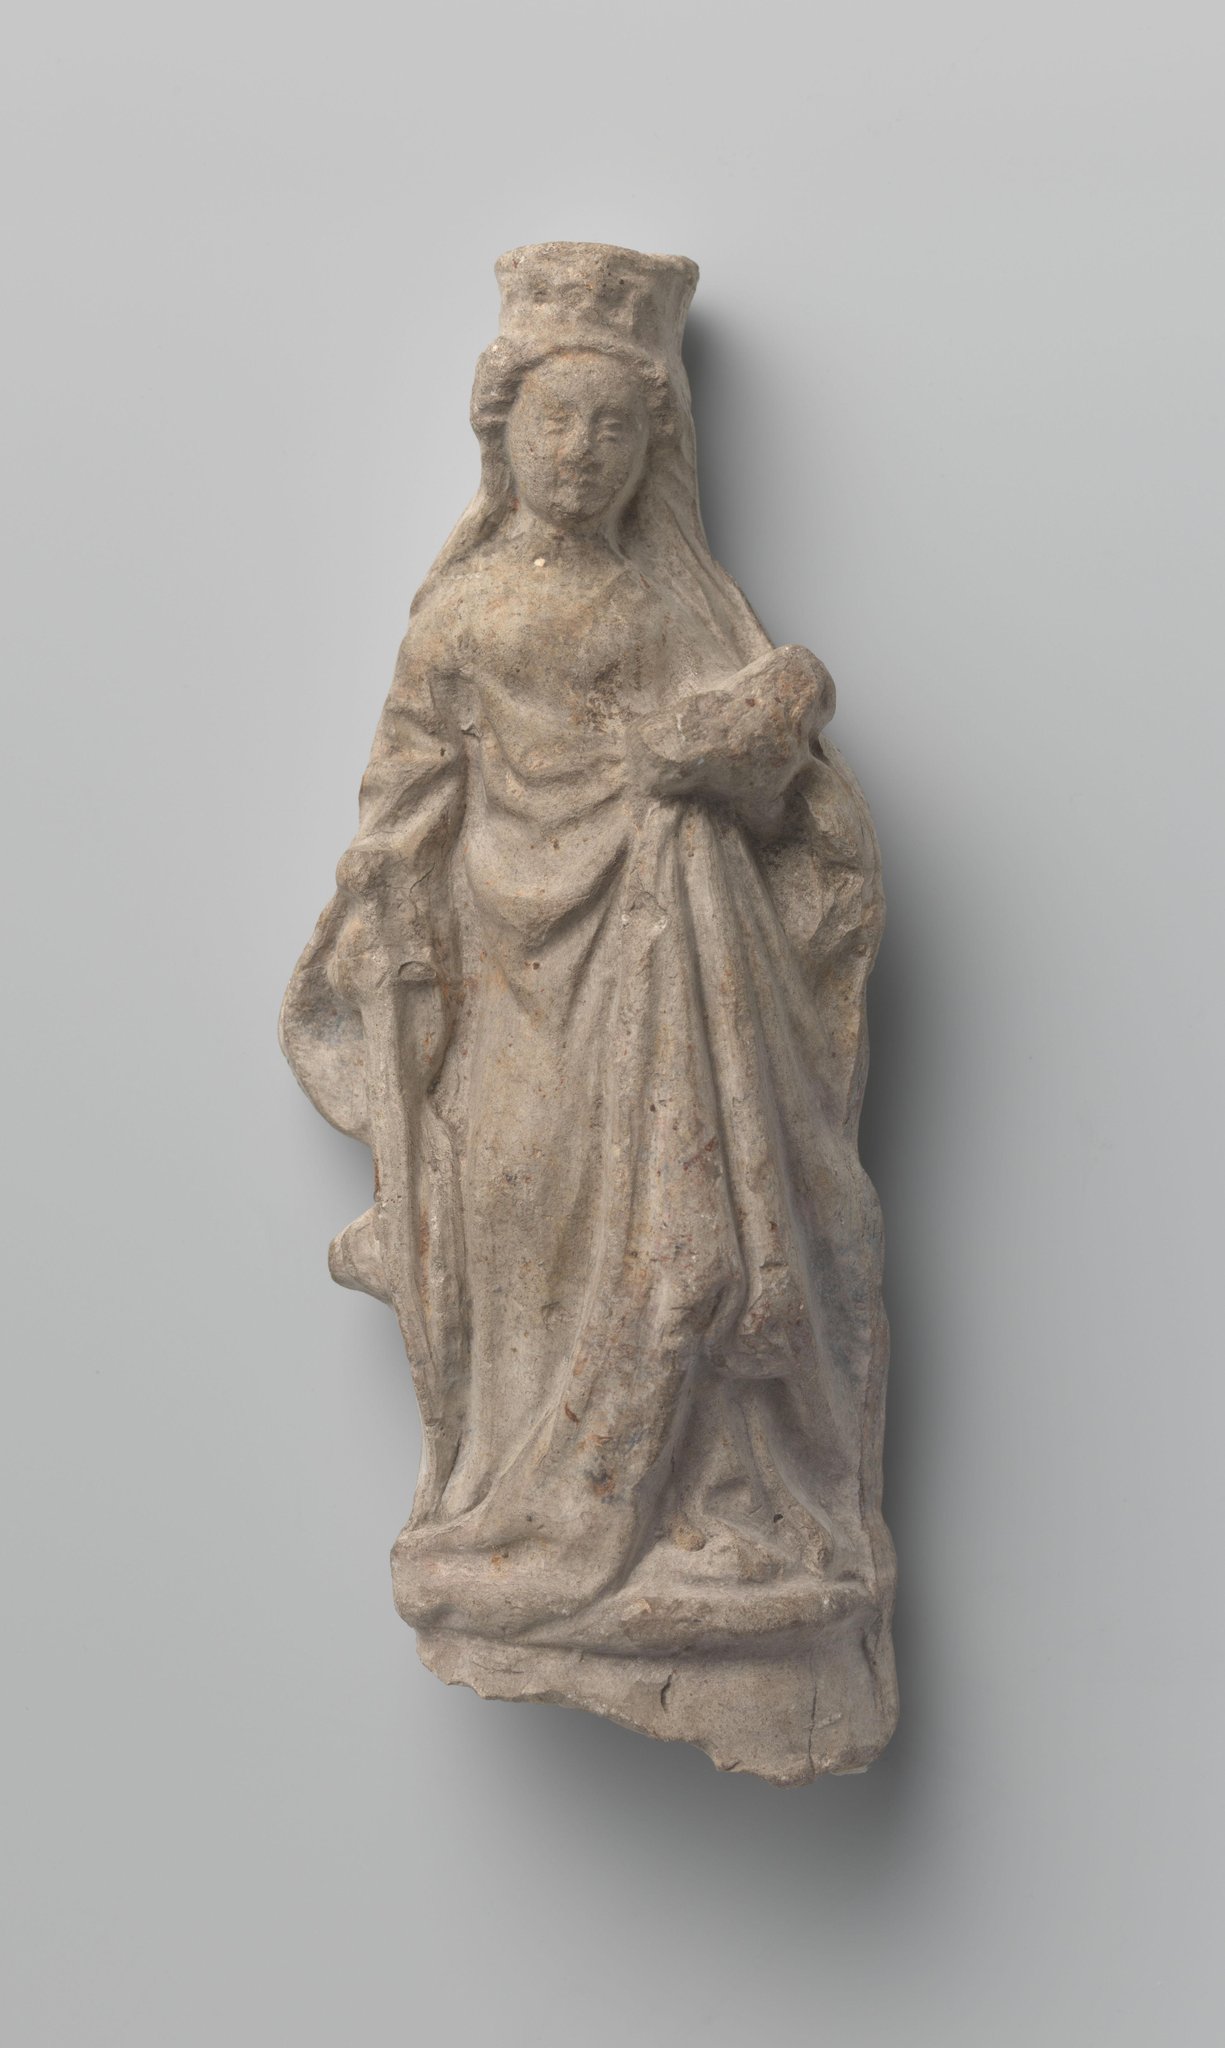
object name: sculpture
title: St Catherine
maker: Anonymous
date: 1475-1500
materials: clay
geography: northern netherlands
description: Beeldhouwwerk van pijpaarde, voorstellende Sint Catharina met het zwaard, het rad en het boek.